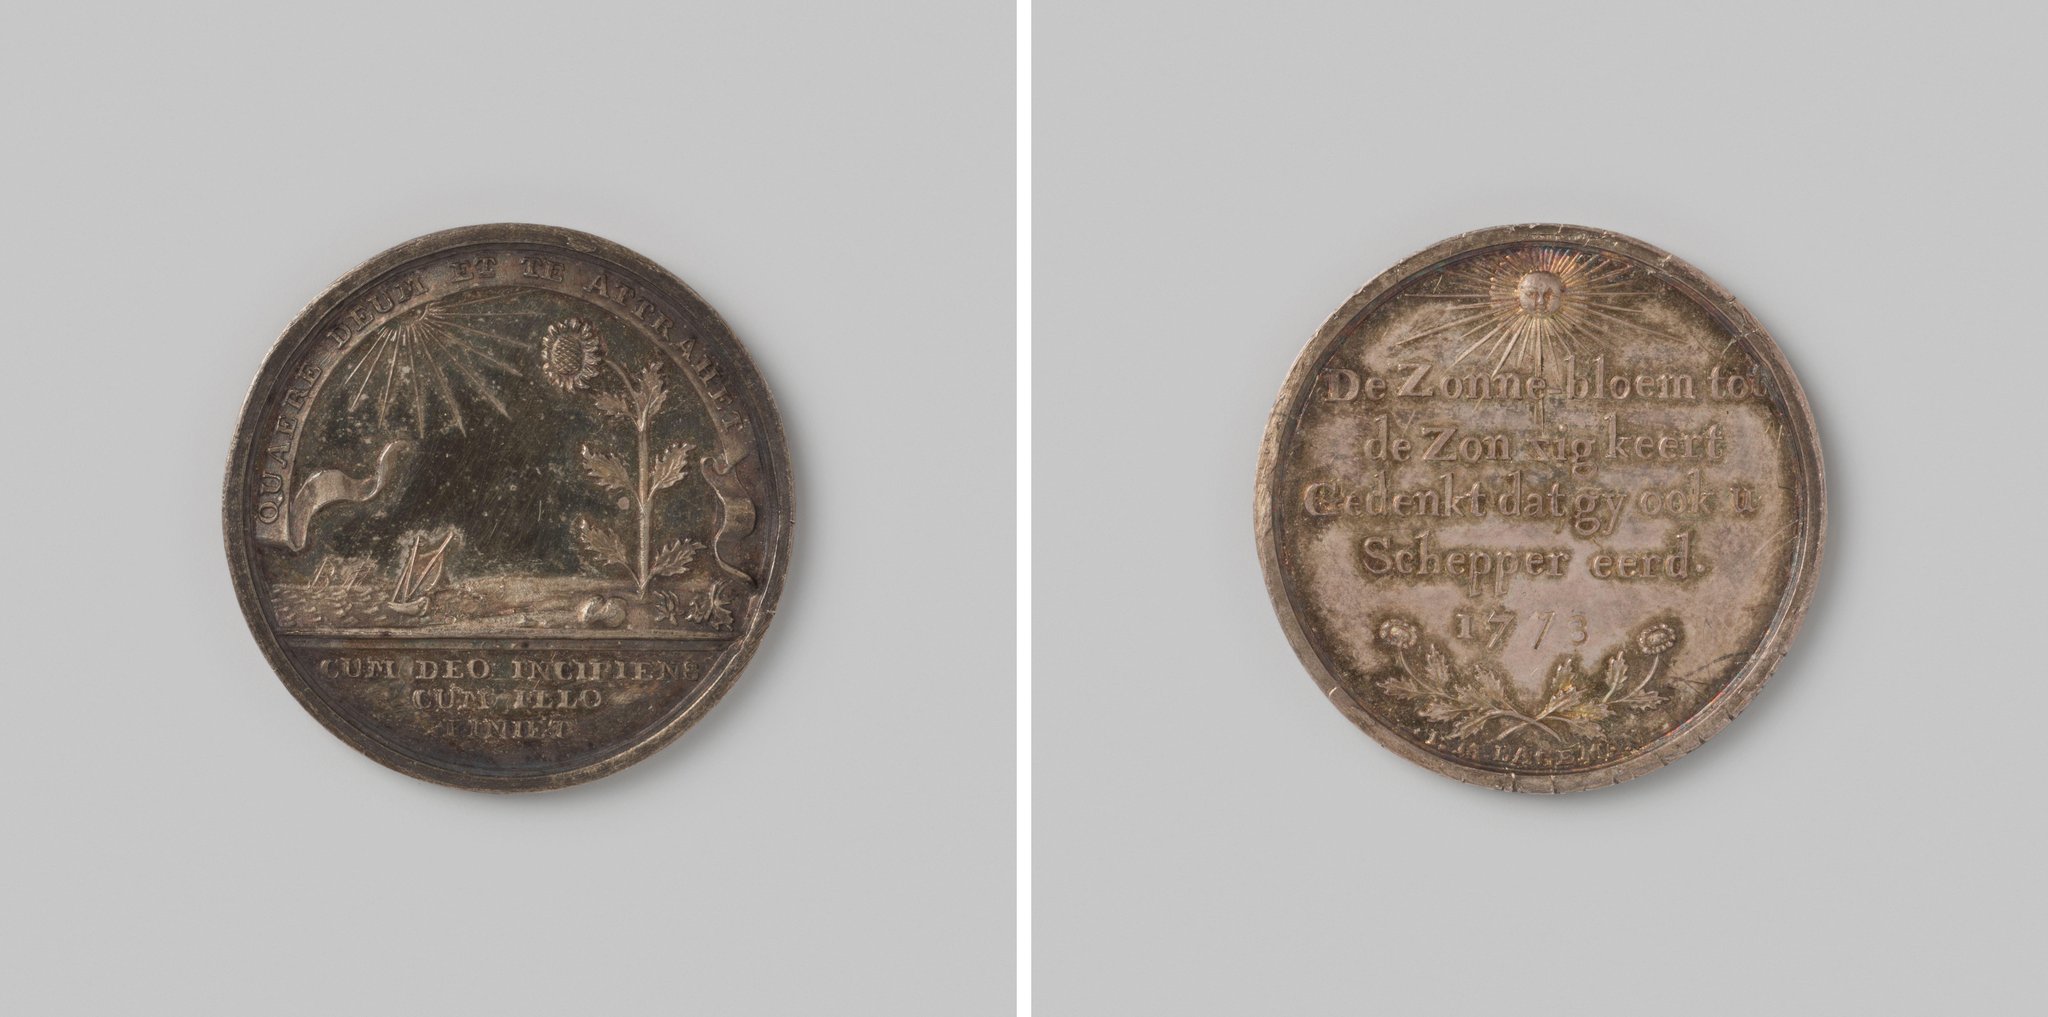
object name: history medal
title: Nieuwjaarspenning met zonnebloem, gedateerd 1778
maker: johannes michiel lageman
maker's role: silversmith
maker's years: 1735-1809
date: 1778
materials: silver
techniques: printing, pressing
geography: amsterdam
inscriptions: inscription: ‘78’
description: Zilveren penning, op de voorzijde een landschap met een zonnebloem, met omschrift op een banderol en afsnedetekst, op de keerzijde vijf regels tekst, bovenaan een zon, onderaan twee zonnebloemranken, het jaartal aangevuld tot 1778